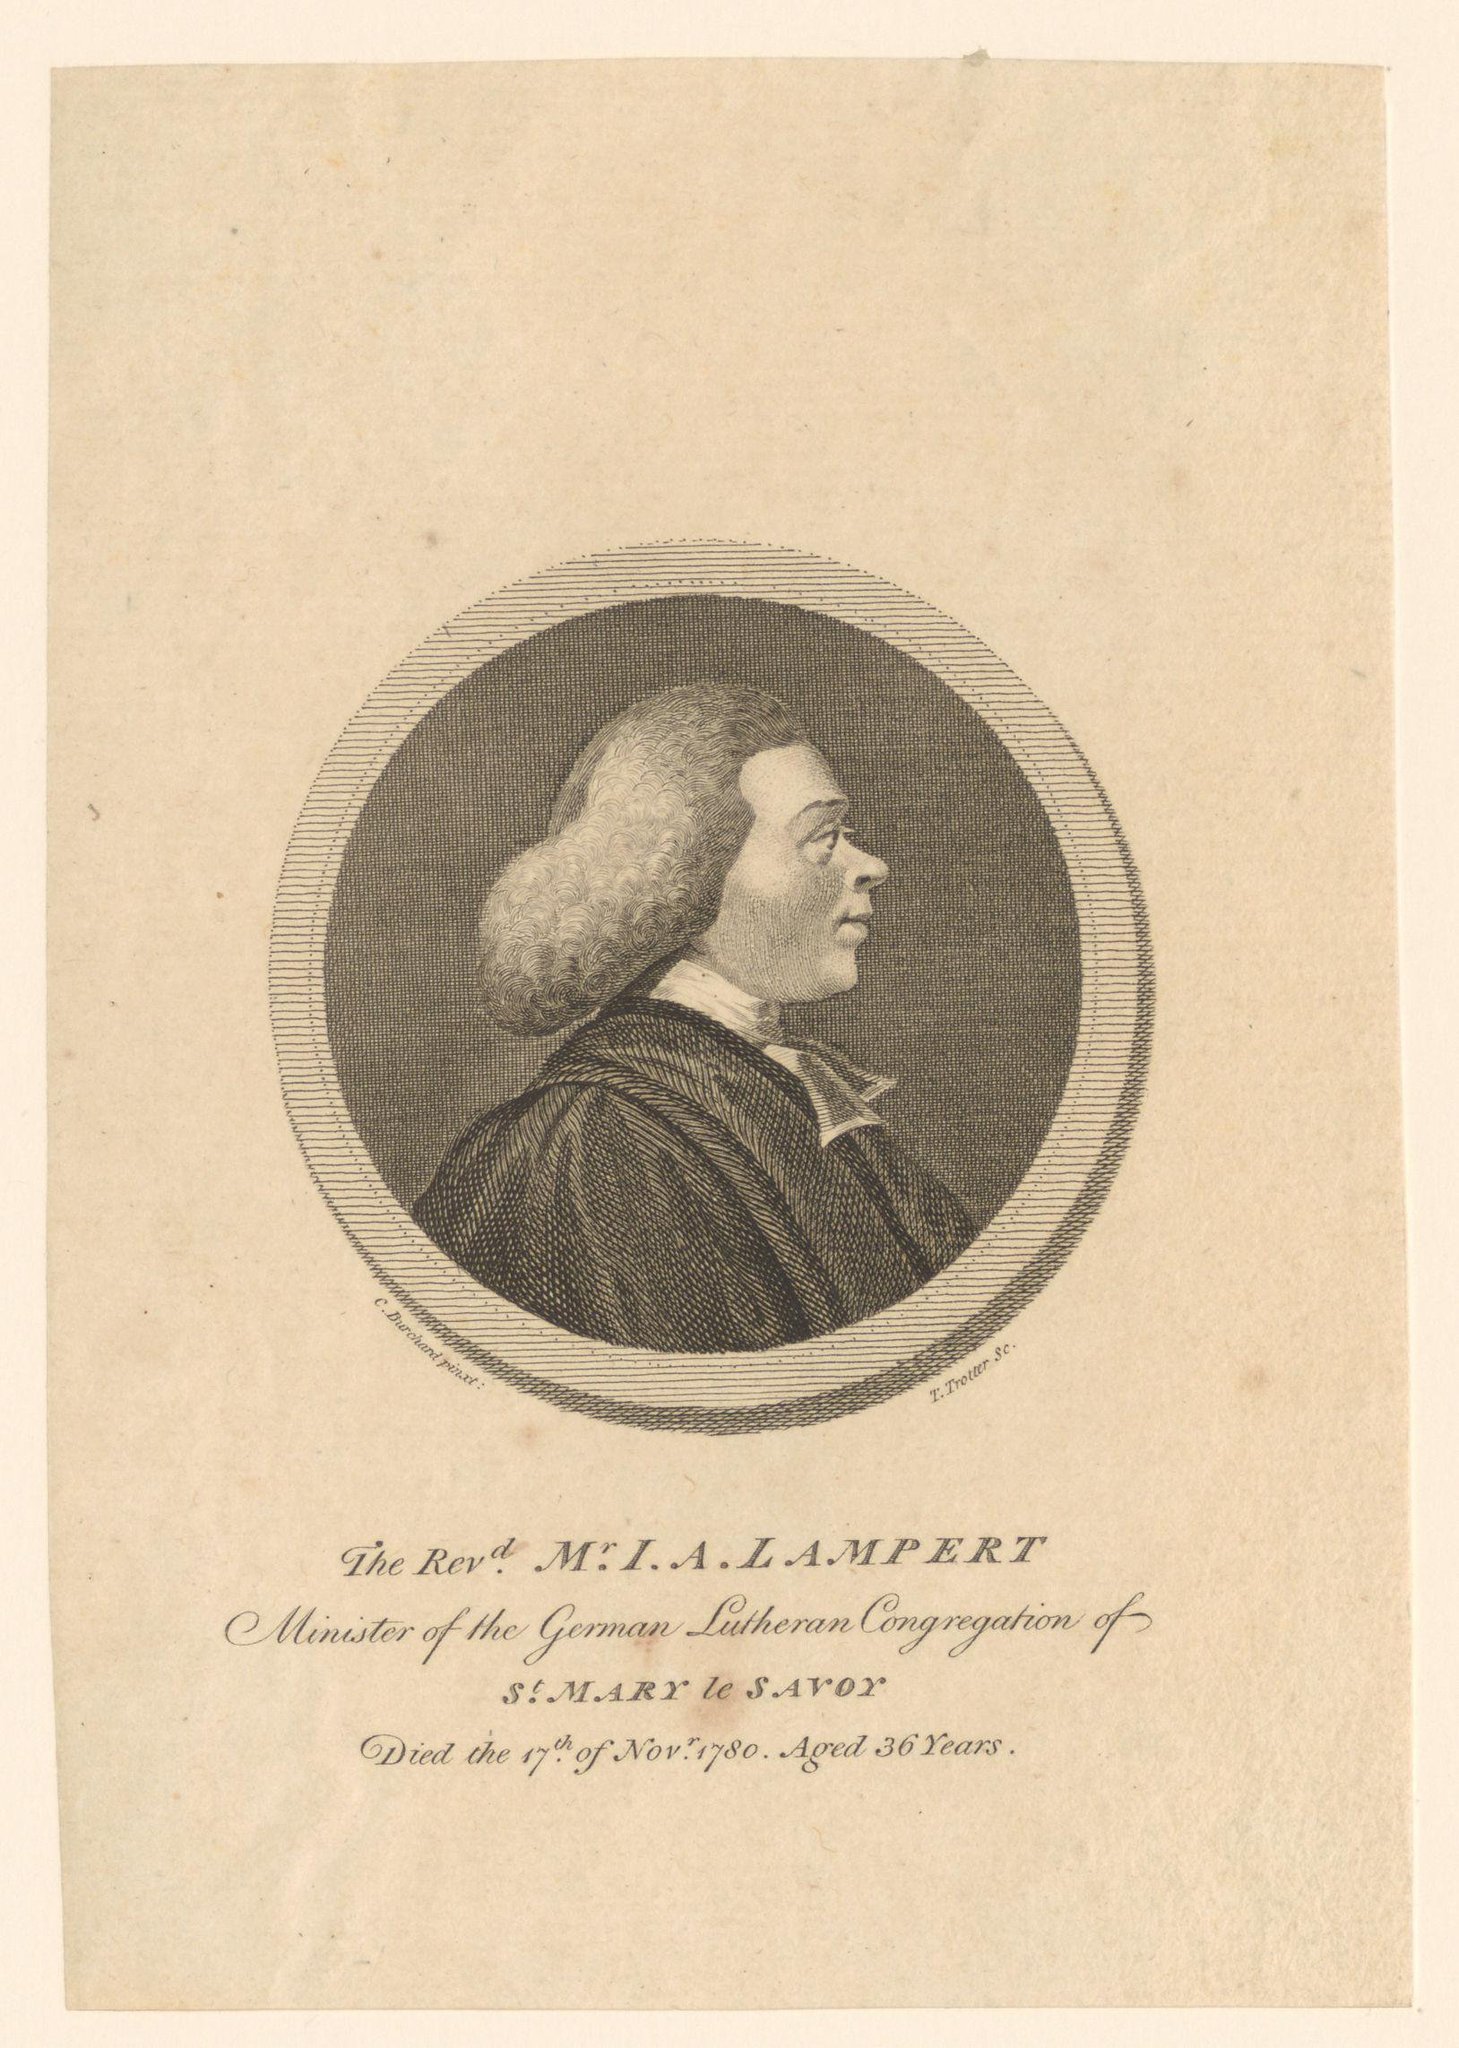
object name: print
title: Portret van J.A. Lampert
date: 1780-1803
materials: paper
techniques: engraving, etching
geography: london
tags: london, theologian, historical persons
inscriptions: collector's mark: Lugt 2228